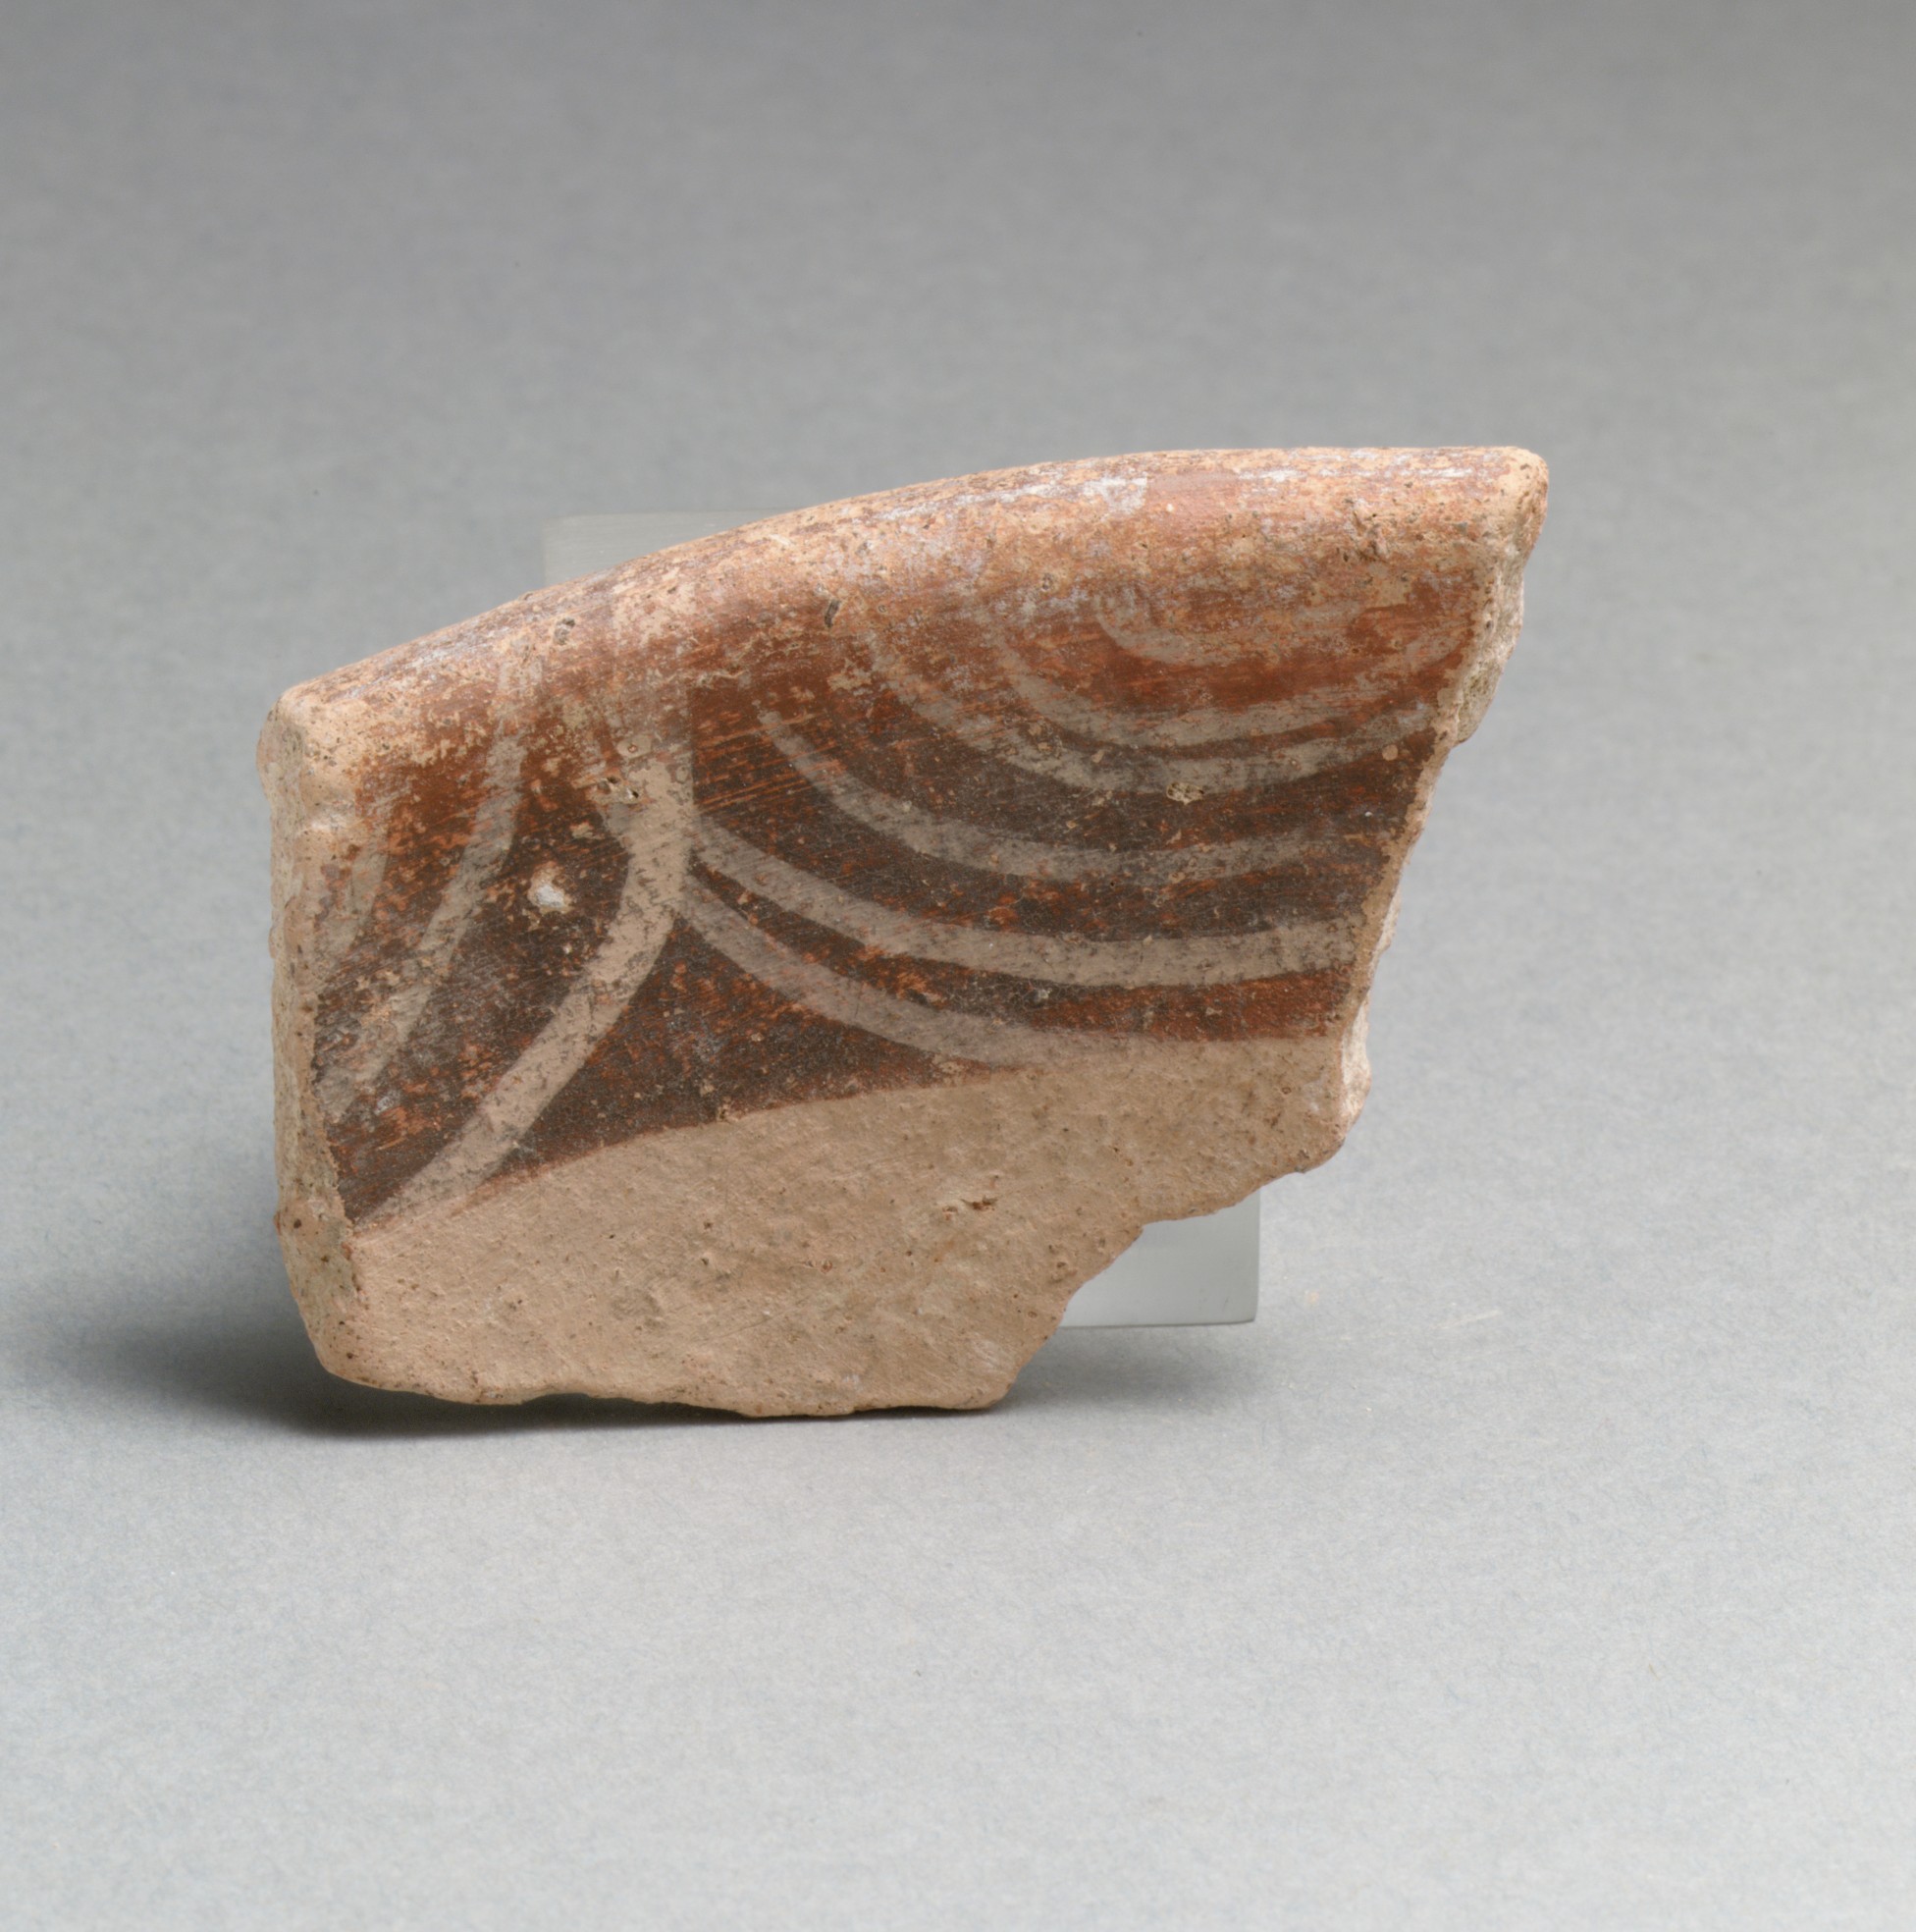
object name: vase fragment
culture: minoan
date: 2600-2000 BCE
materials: terracotta